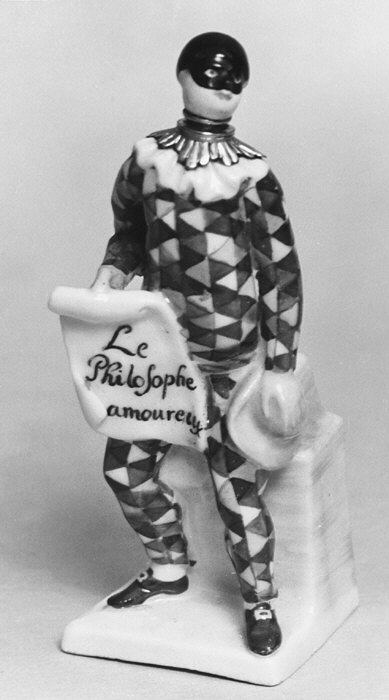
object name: scent bottle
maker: kloster-veilsdorf porcelain manufactory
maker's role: manufactory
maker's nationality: german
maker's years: 1760-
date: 1775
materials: hard paste porcelain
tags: men